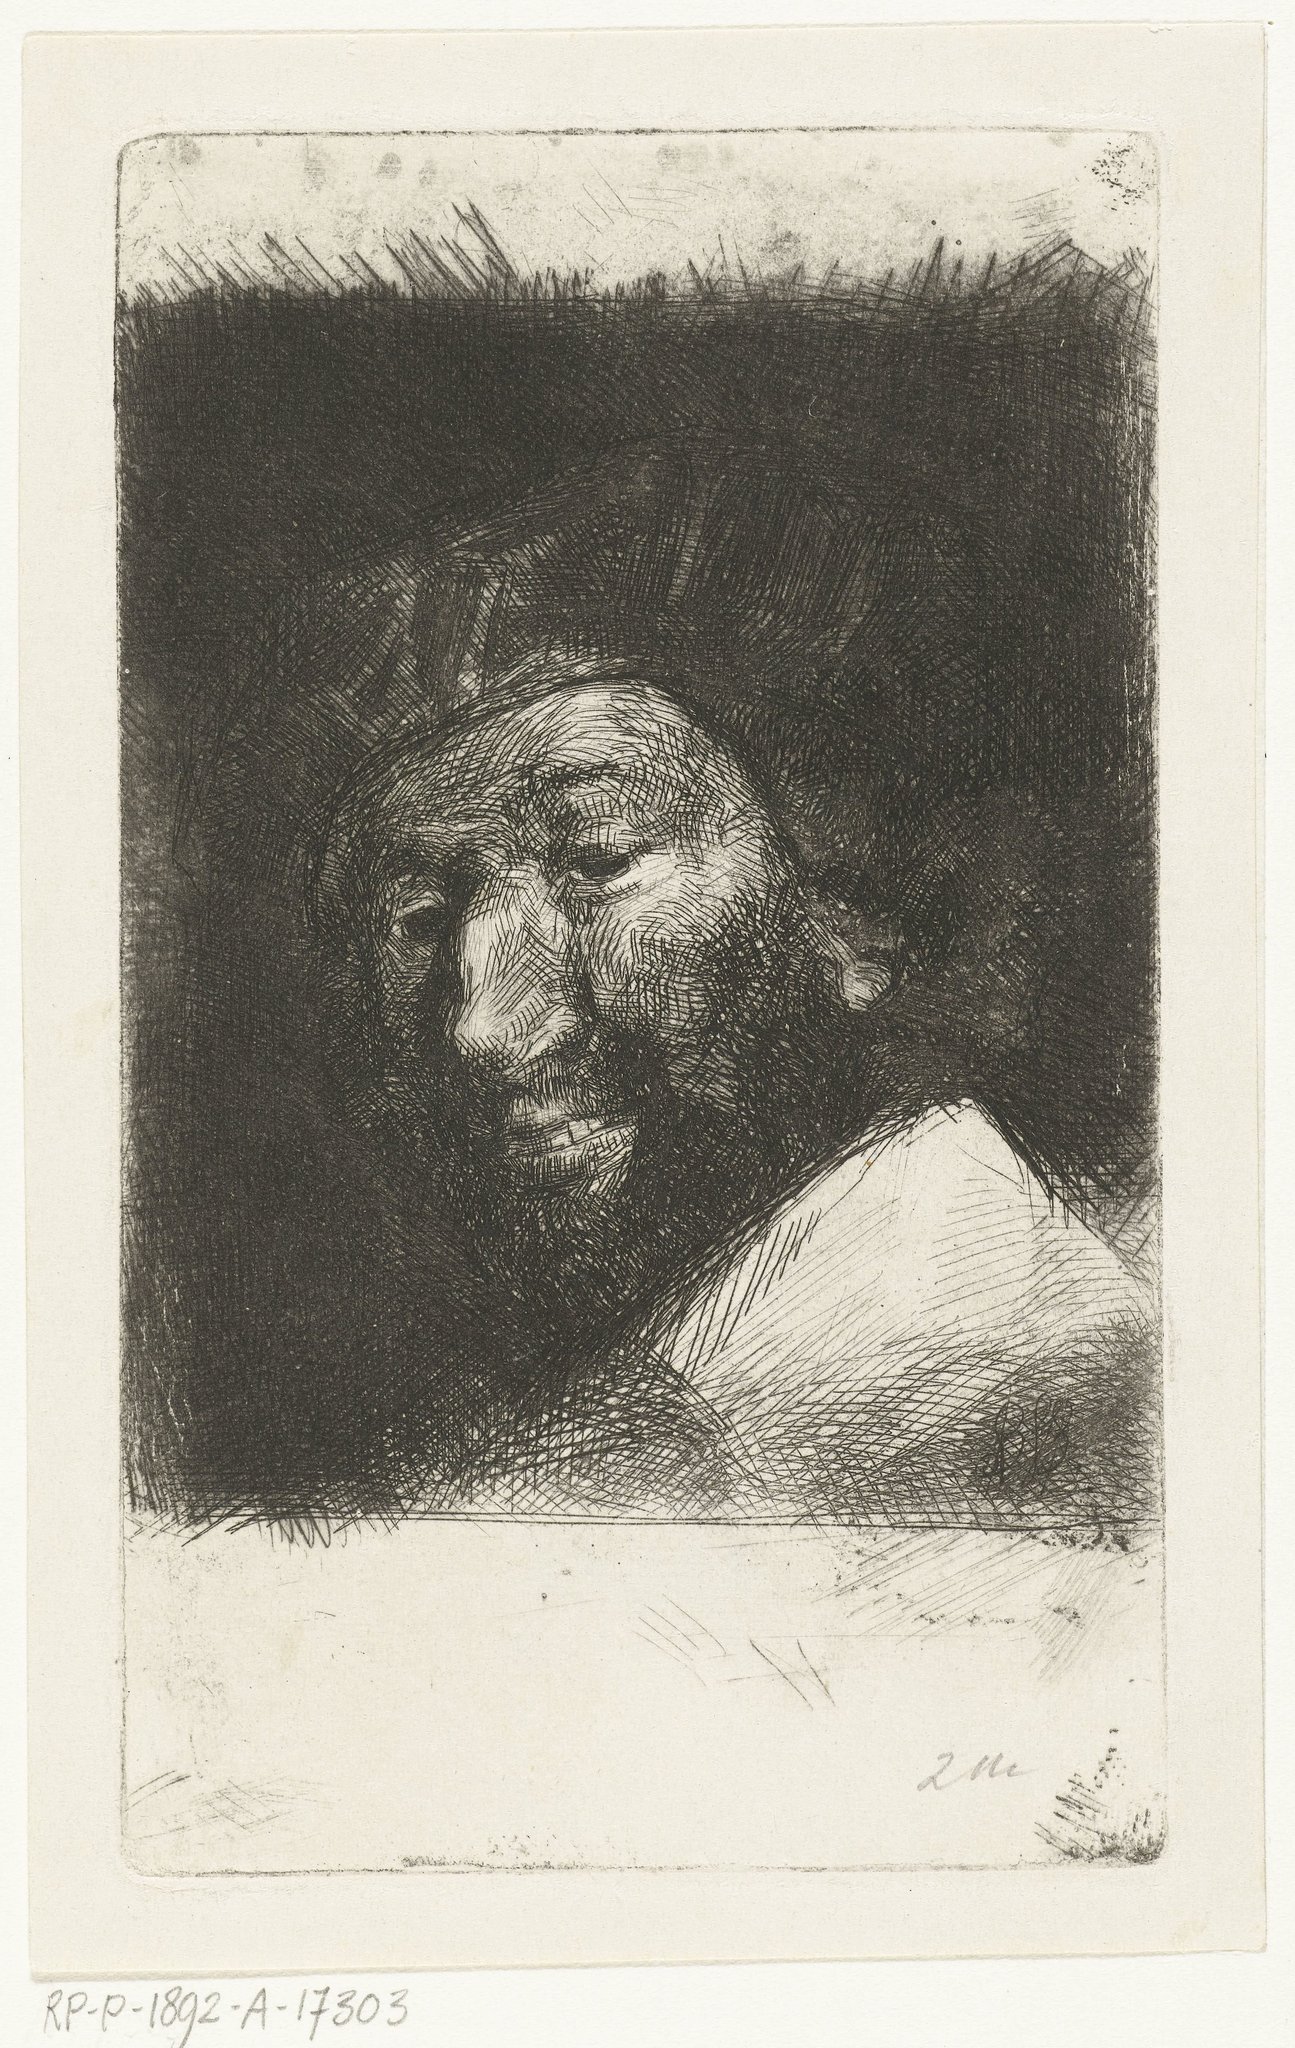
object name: print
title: Portret van lachende man met baard en muts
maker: bernardus johannes blommers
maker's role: draughtsman, print maker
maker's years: 1845-1914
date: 1855-1892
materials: paper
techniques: drypoint, etching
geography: netherlands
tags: laughing, portrait, self-portrait of artist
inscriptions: collector's mark: Lugt 2228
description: Portret of buste van lachende man met baard en schildersmuts.